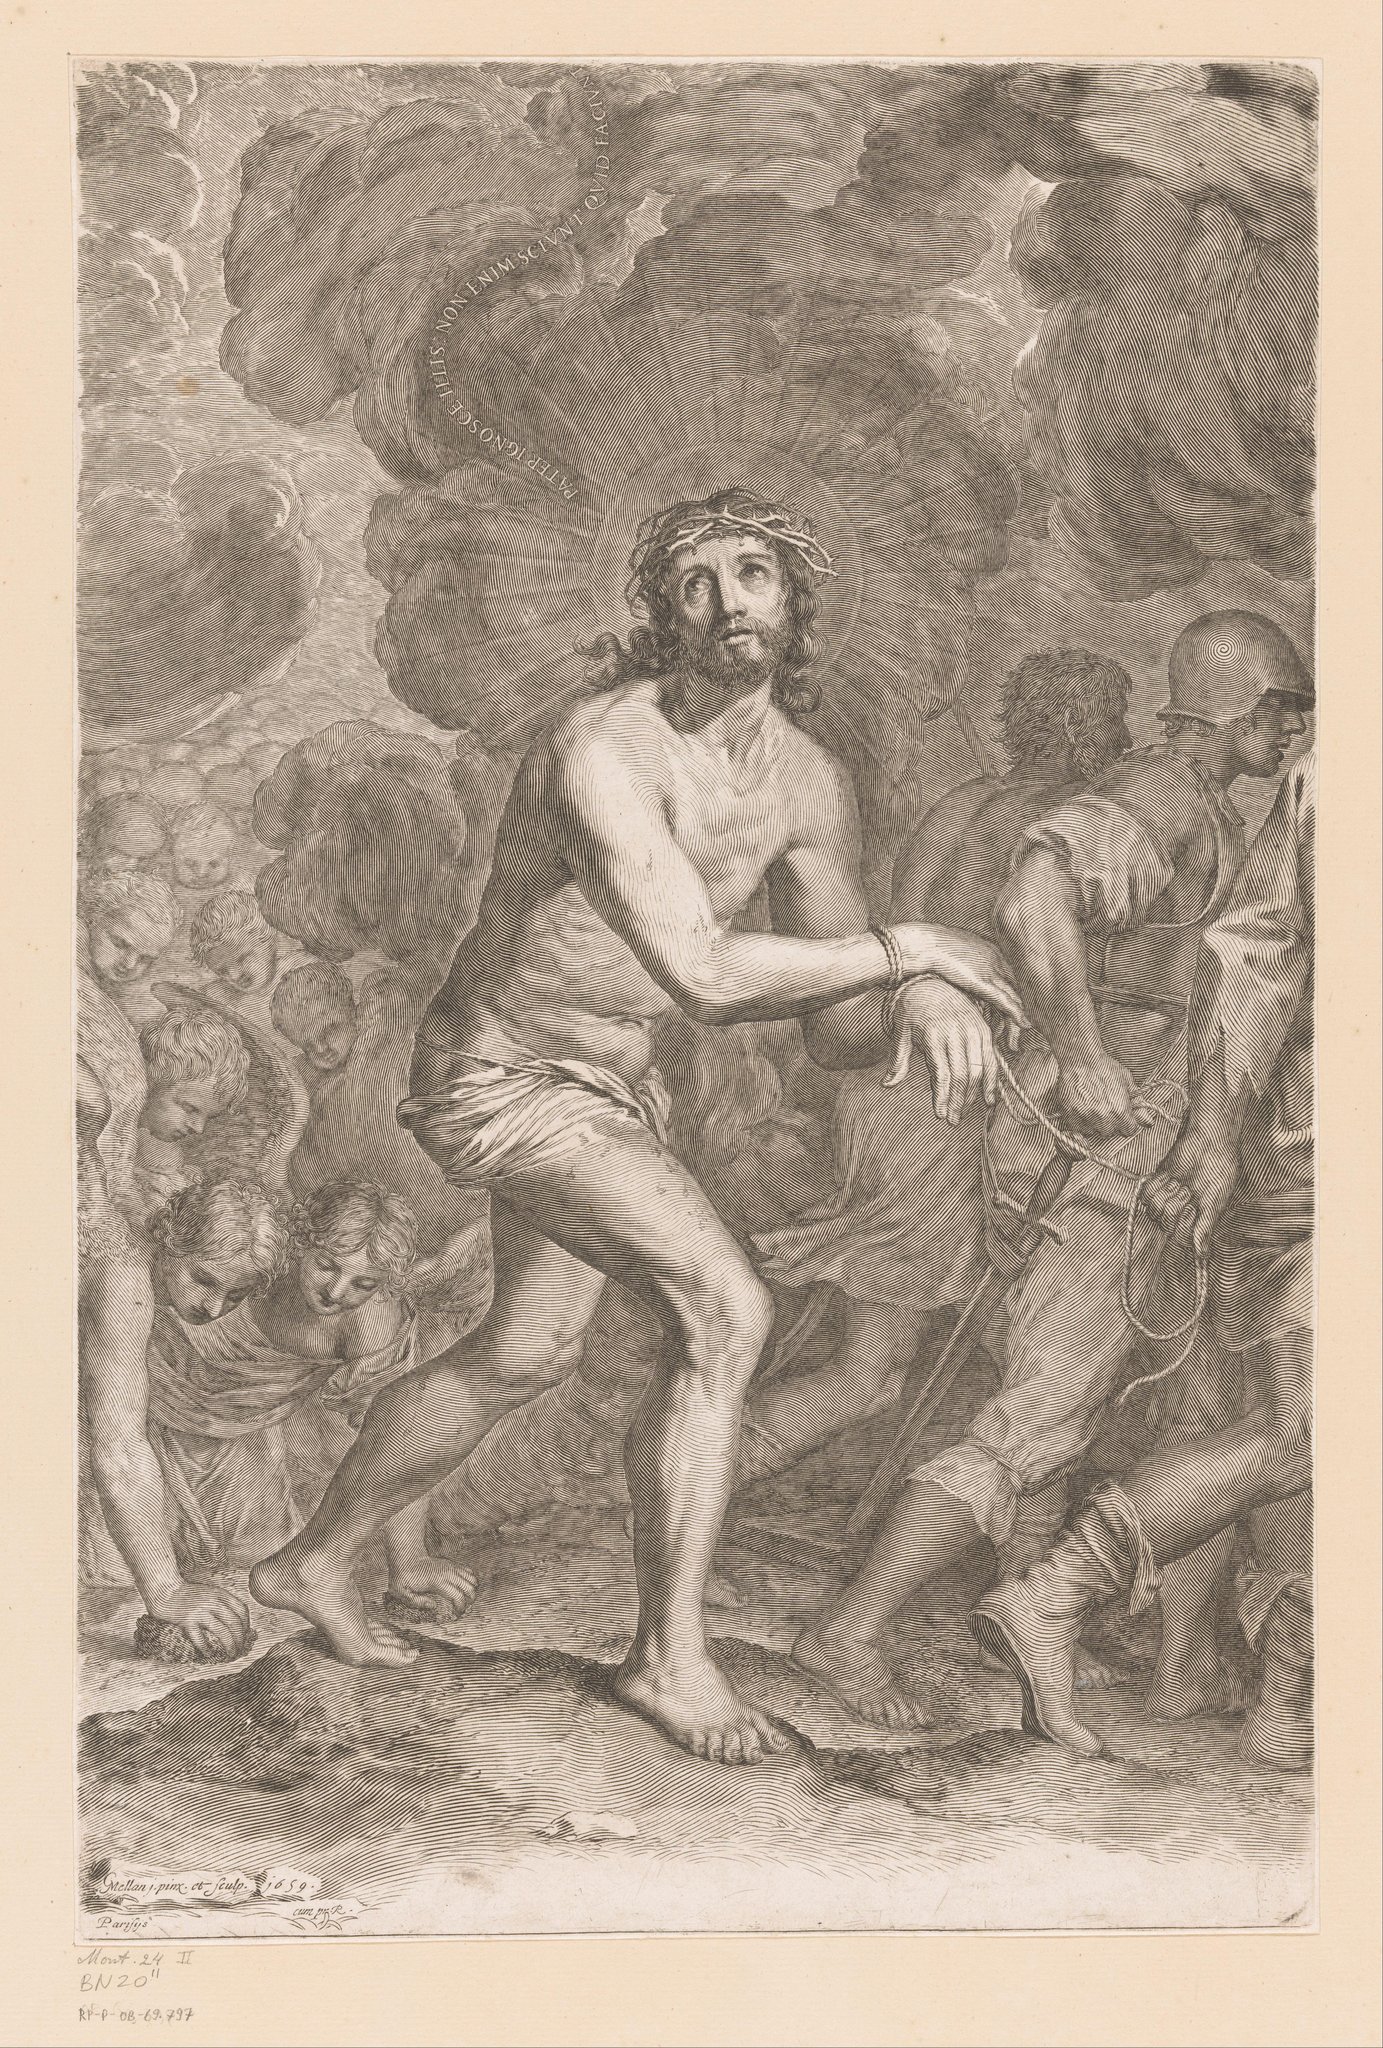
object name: print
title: Tocht naar de Calvarieberg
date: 1659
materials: paper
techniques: engraving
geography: france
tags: from pilate's palace to golgotha: the procession to calvary (matthew 27:31-33; mark 15:20-22; luke 23:26-33; john 19:17)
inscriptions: collector's mark: Lugt 240